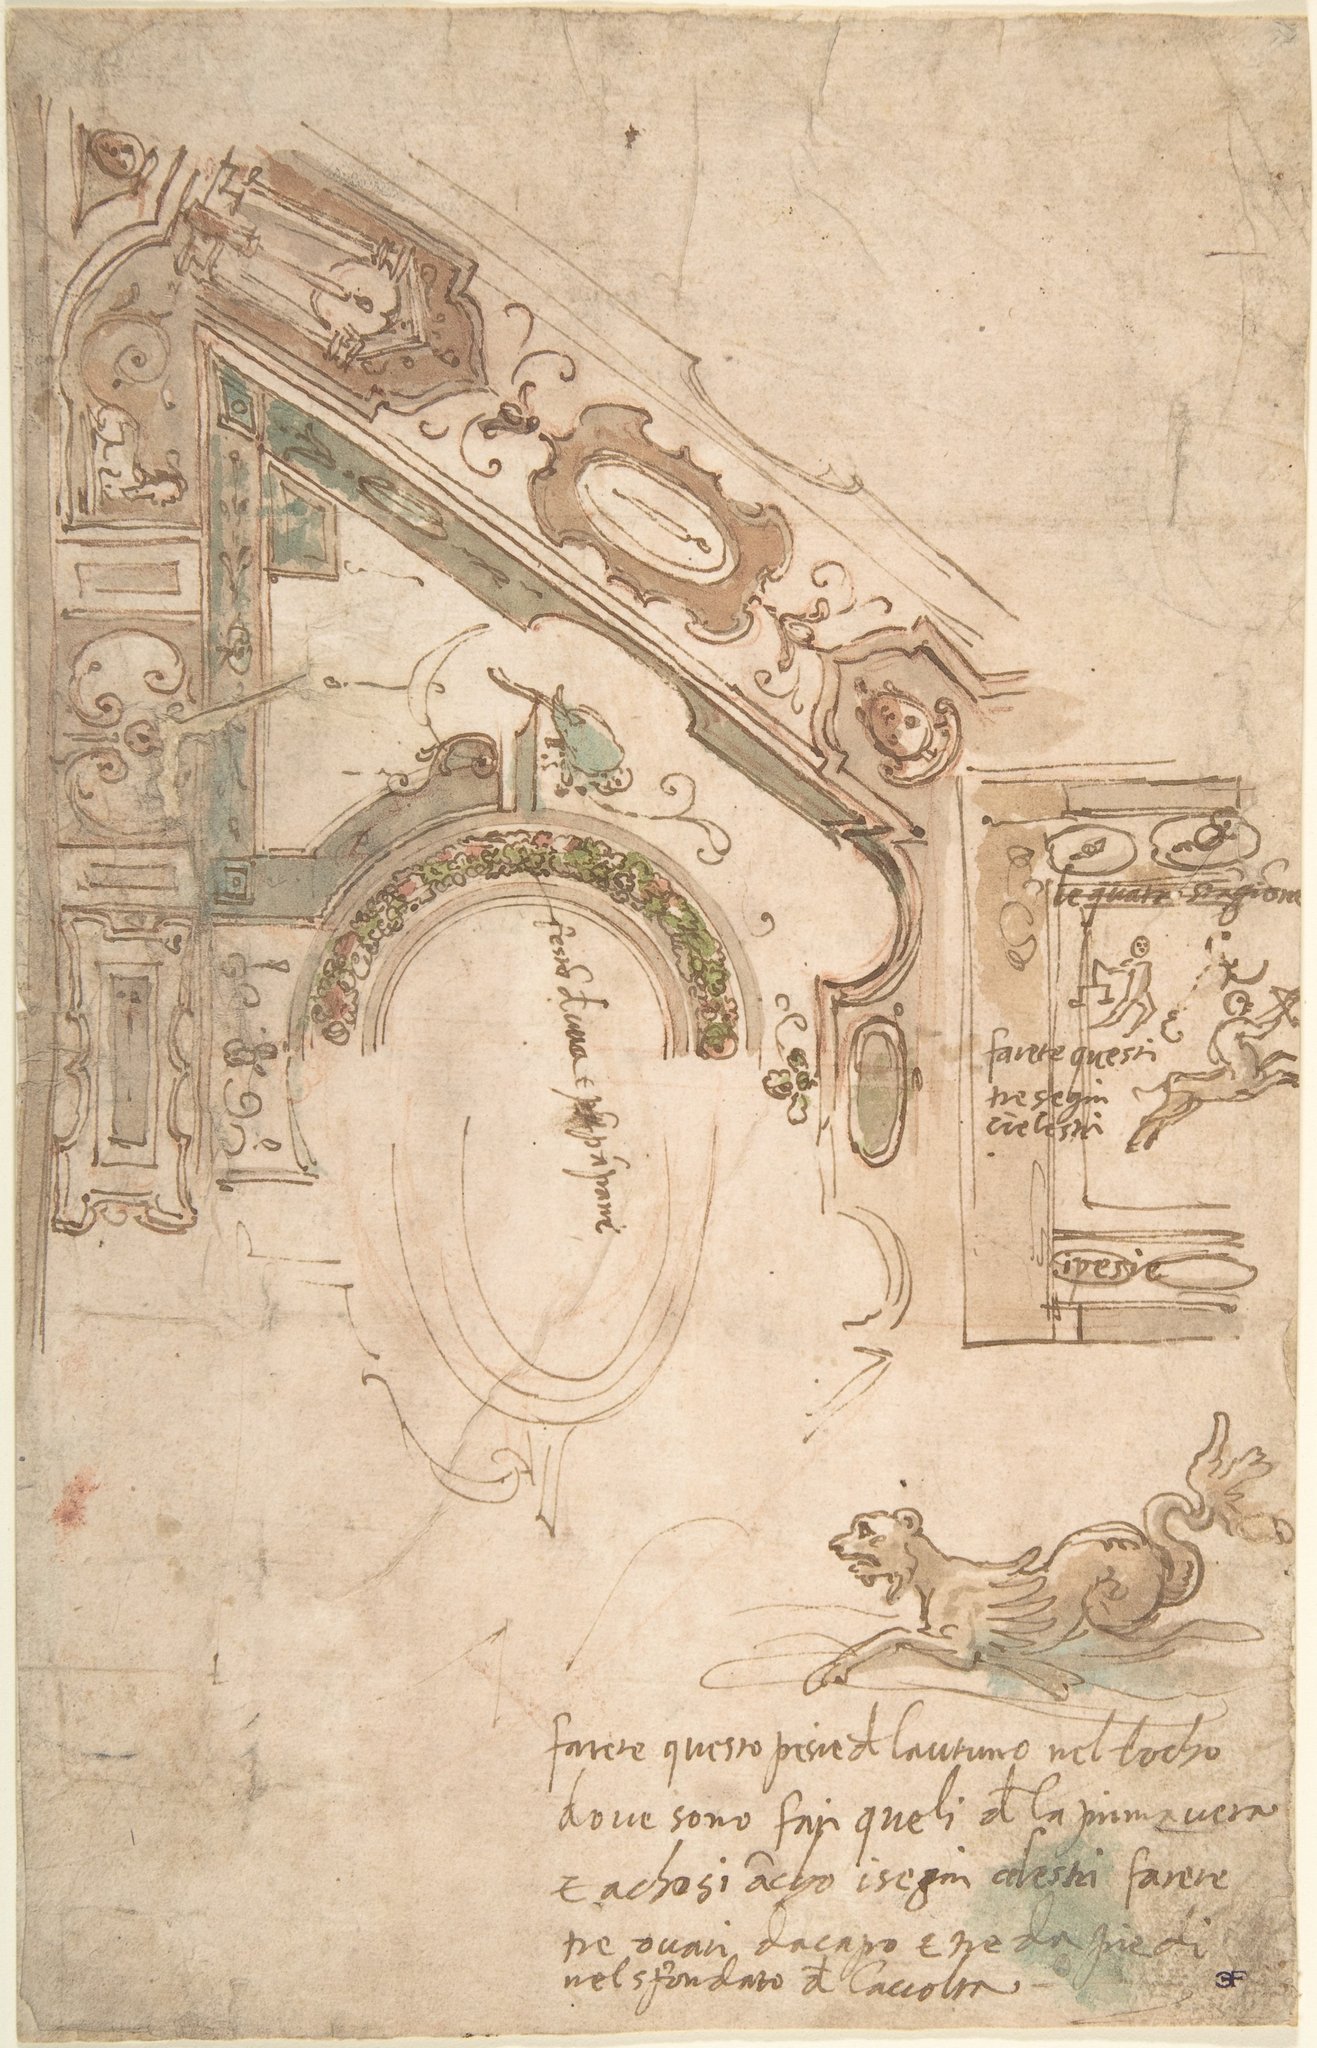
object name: drawing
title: Quarter Plan for a Coved Ceiling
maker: antenore ridolfi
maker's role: artist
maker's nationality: italian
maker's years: 1538-1575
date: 1561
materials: chalk, ink, watercolor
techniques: brush, pen, wash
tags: ceilings